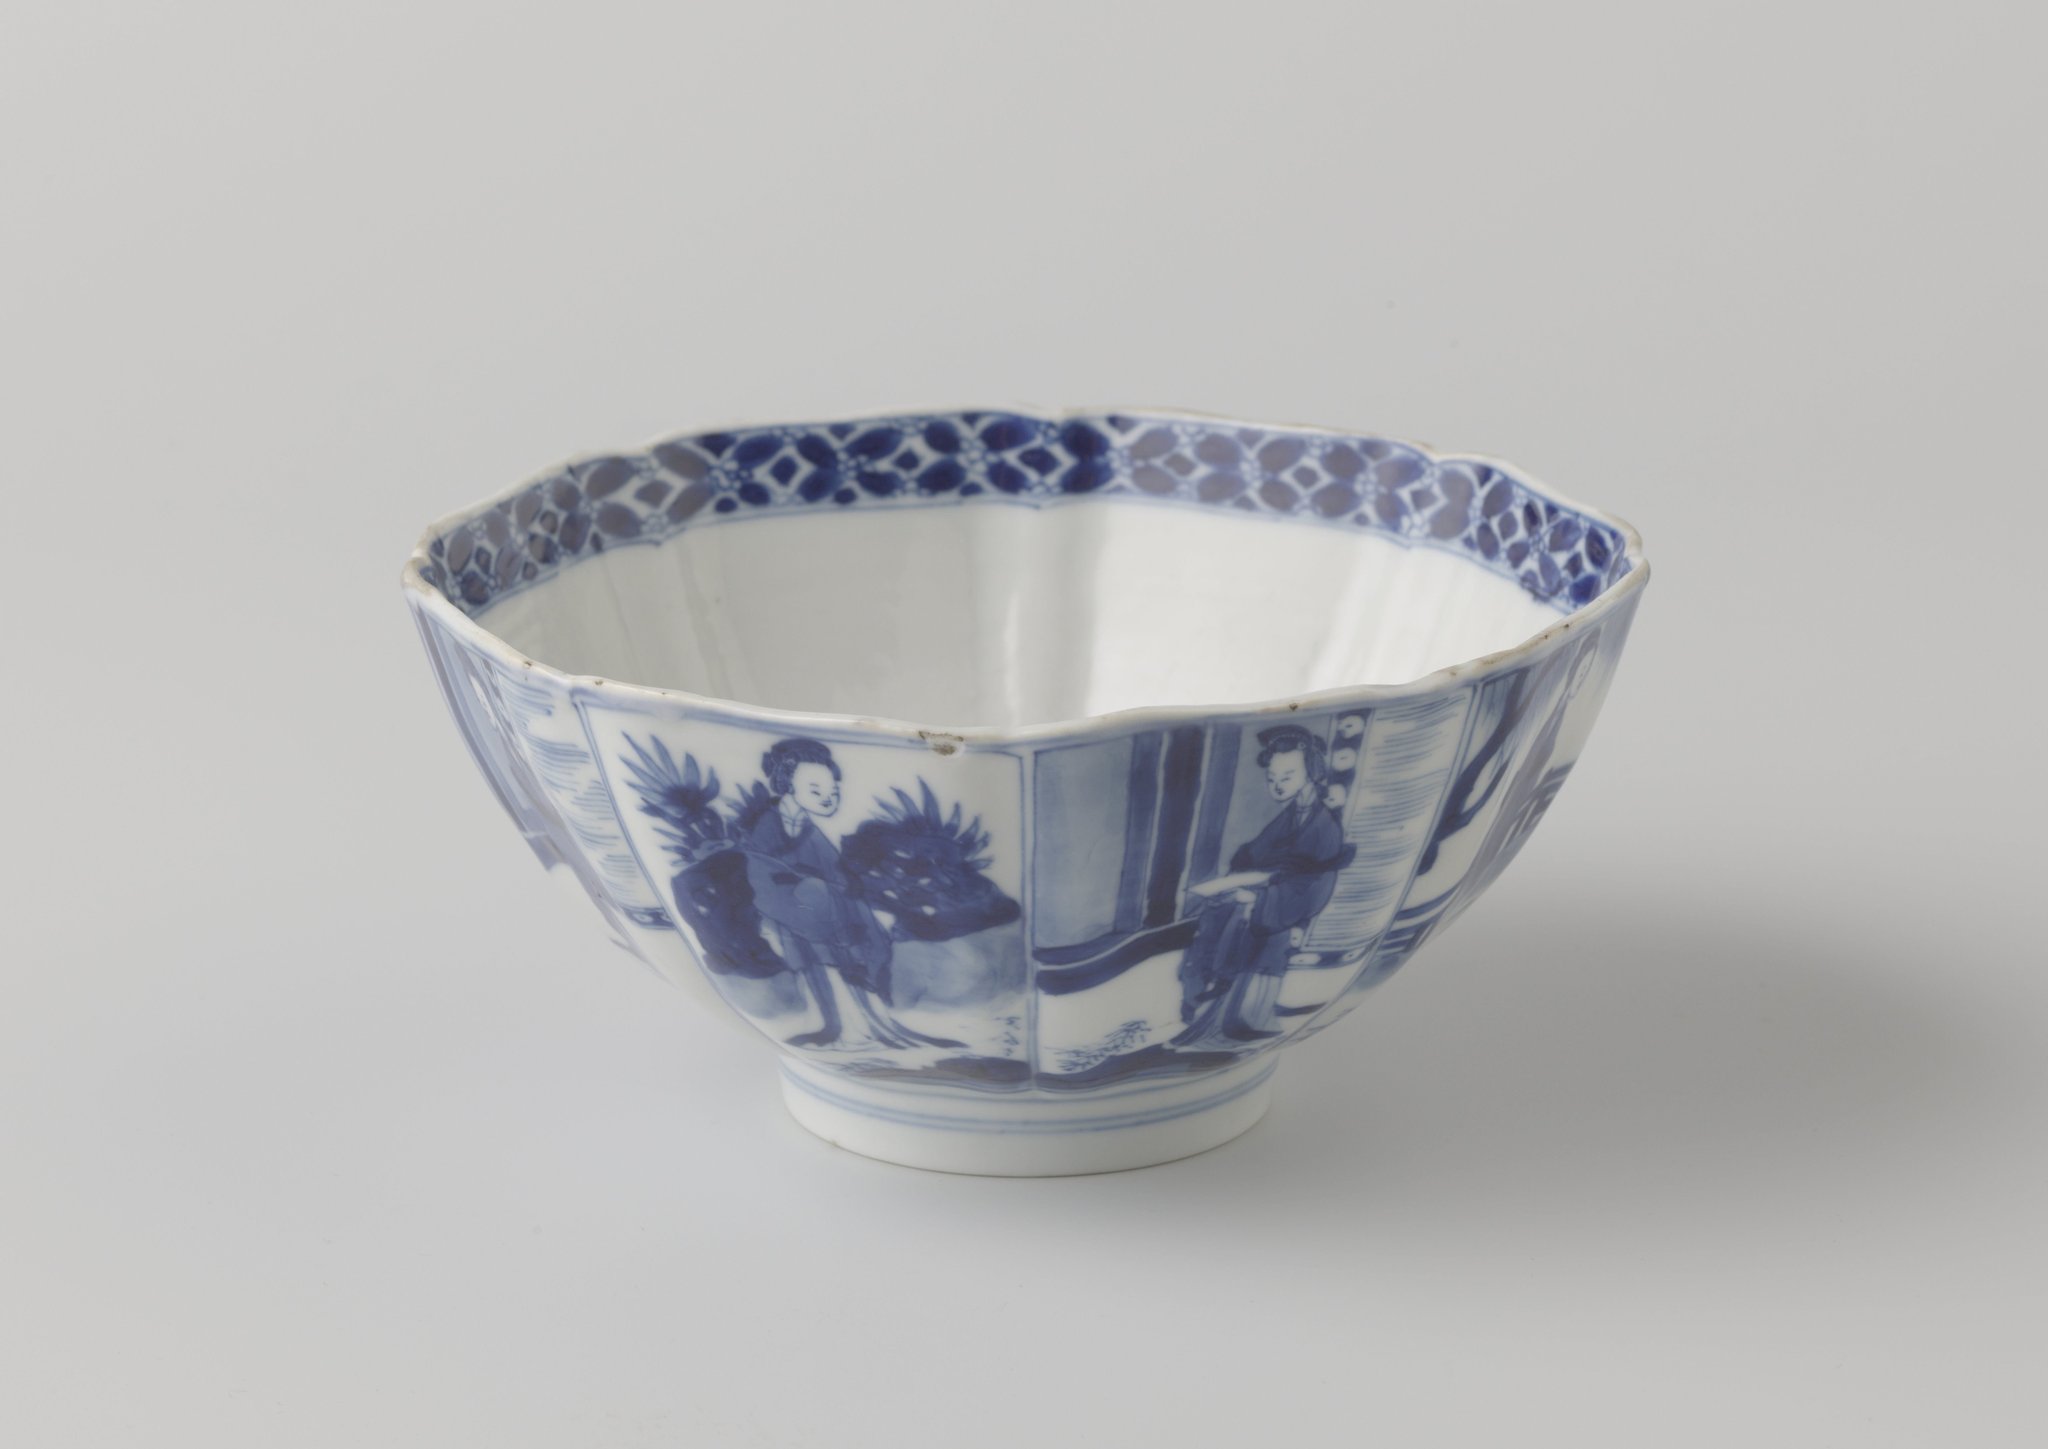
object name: bowl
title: Octagonal bowl with women on a terras and playing boys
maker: Anonymous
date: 1680-1720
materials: cobalt, glaze, paint, porcelain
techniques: firing, turning, vitrification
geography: china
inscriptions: mark: ‘大 明 成 化 年 製’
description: Achthoekige kom van porselein met ingeknepen hoeken, beschilderd in onderglazuur blauw. Op de buitenwand acht vakken met in elk een vrouw (lange lijs) in een omheinde tuin of op een terras, soms met een ruyi-scepter of waaier in haar hand. Op de bodem twee spelende jongens (zotjes) met een bal in een landschap. De binnenrand met een decoratieve band. Gemerkt met het zes-karaktermerk van keizer Chenghua in een dubbele cirkel. Blauw-wit.